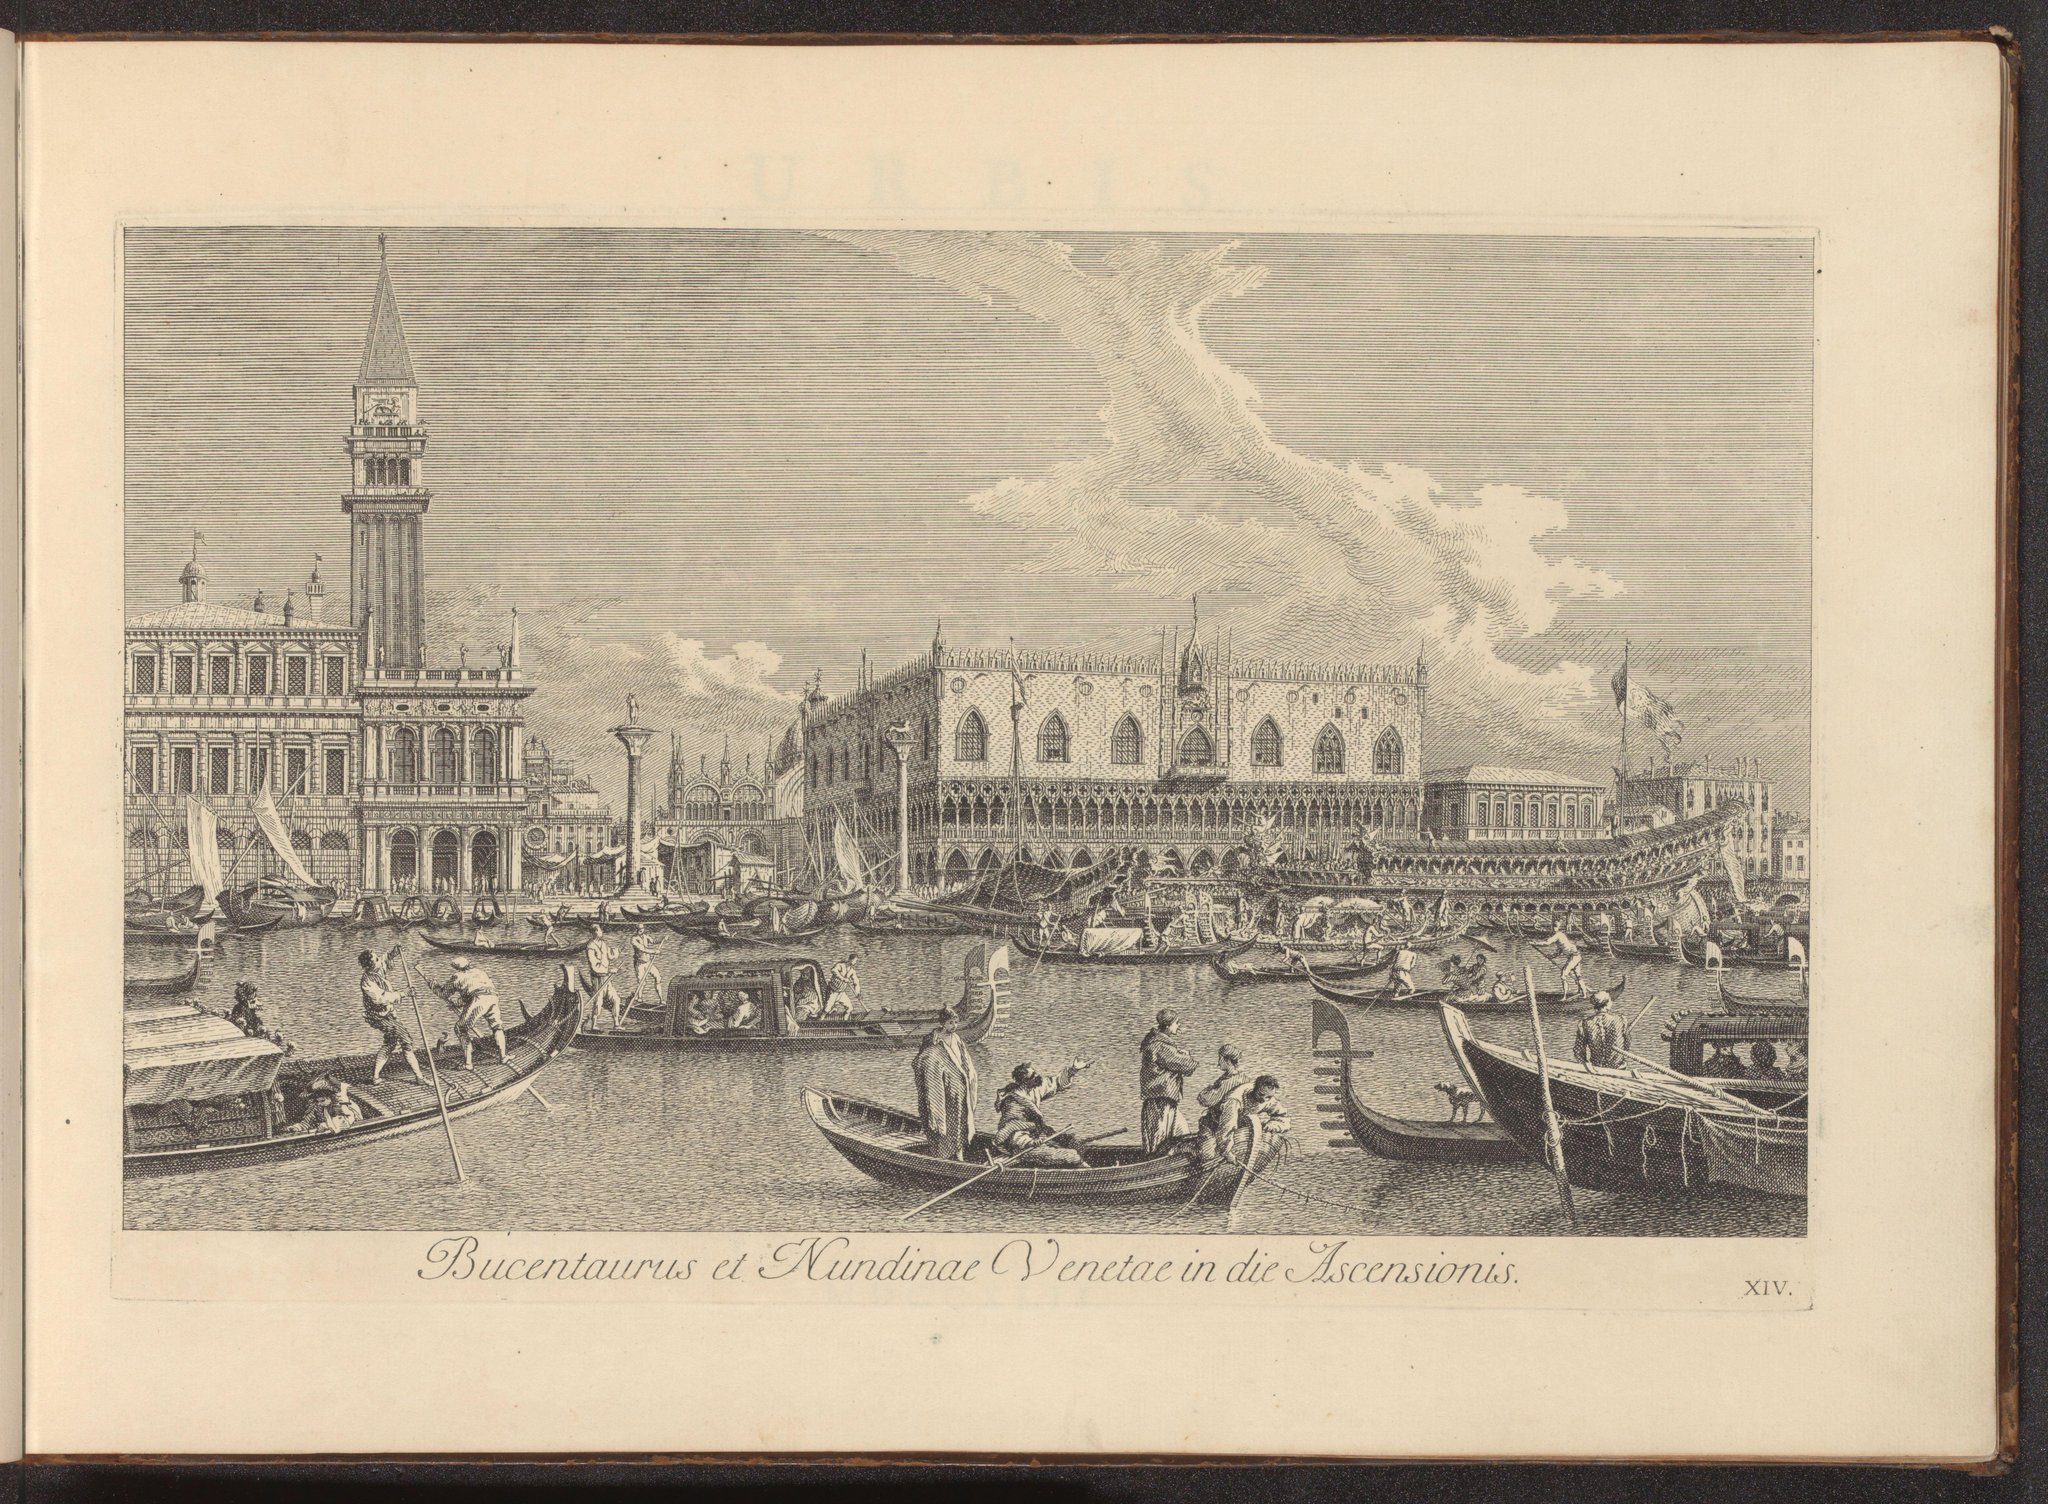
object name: print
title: Gezichten op grote kanalen in Venetië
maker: antonio visentini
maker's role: draughtsman, print maker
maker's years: 1688-1782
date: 1742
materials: paper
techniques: etching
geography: venice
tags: city-view, and landscape with man-made constructions, canal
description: Gezicht op het Canal Grande te Venetië. Op het water een kluwen aan gondels en schepen. Centraal de Bucintoro, de galei van de doge. Eens per jaar "huwde" de doge tijdens het Festa della Sensa op ceremoniële wijze met de Adriatische Zee door vanaf deze schitterende galei een ring in het water te werpen. De prent maakt deel uit van een album.